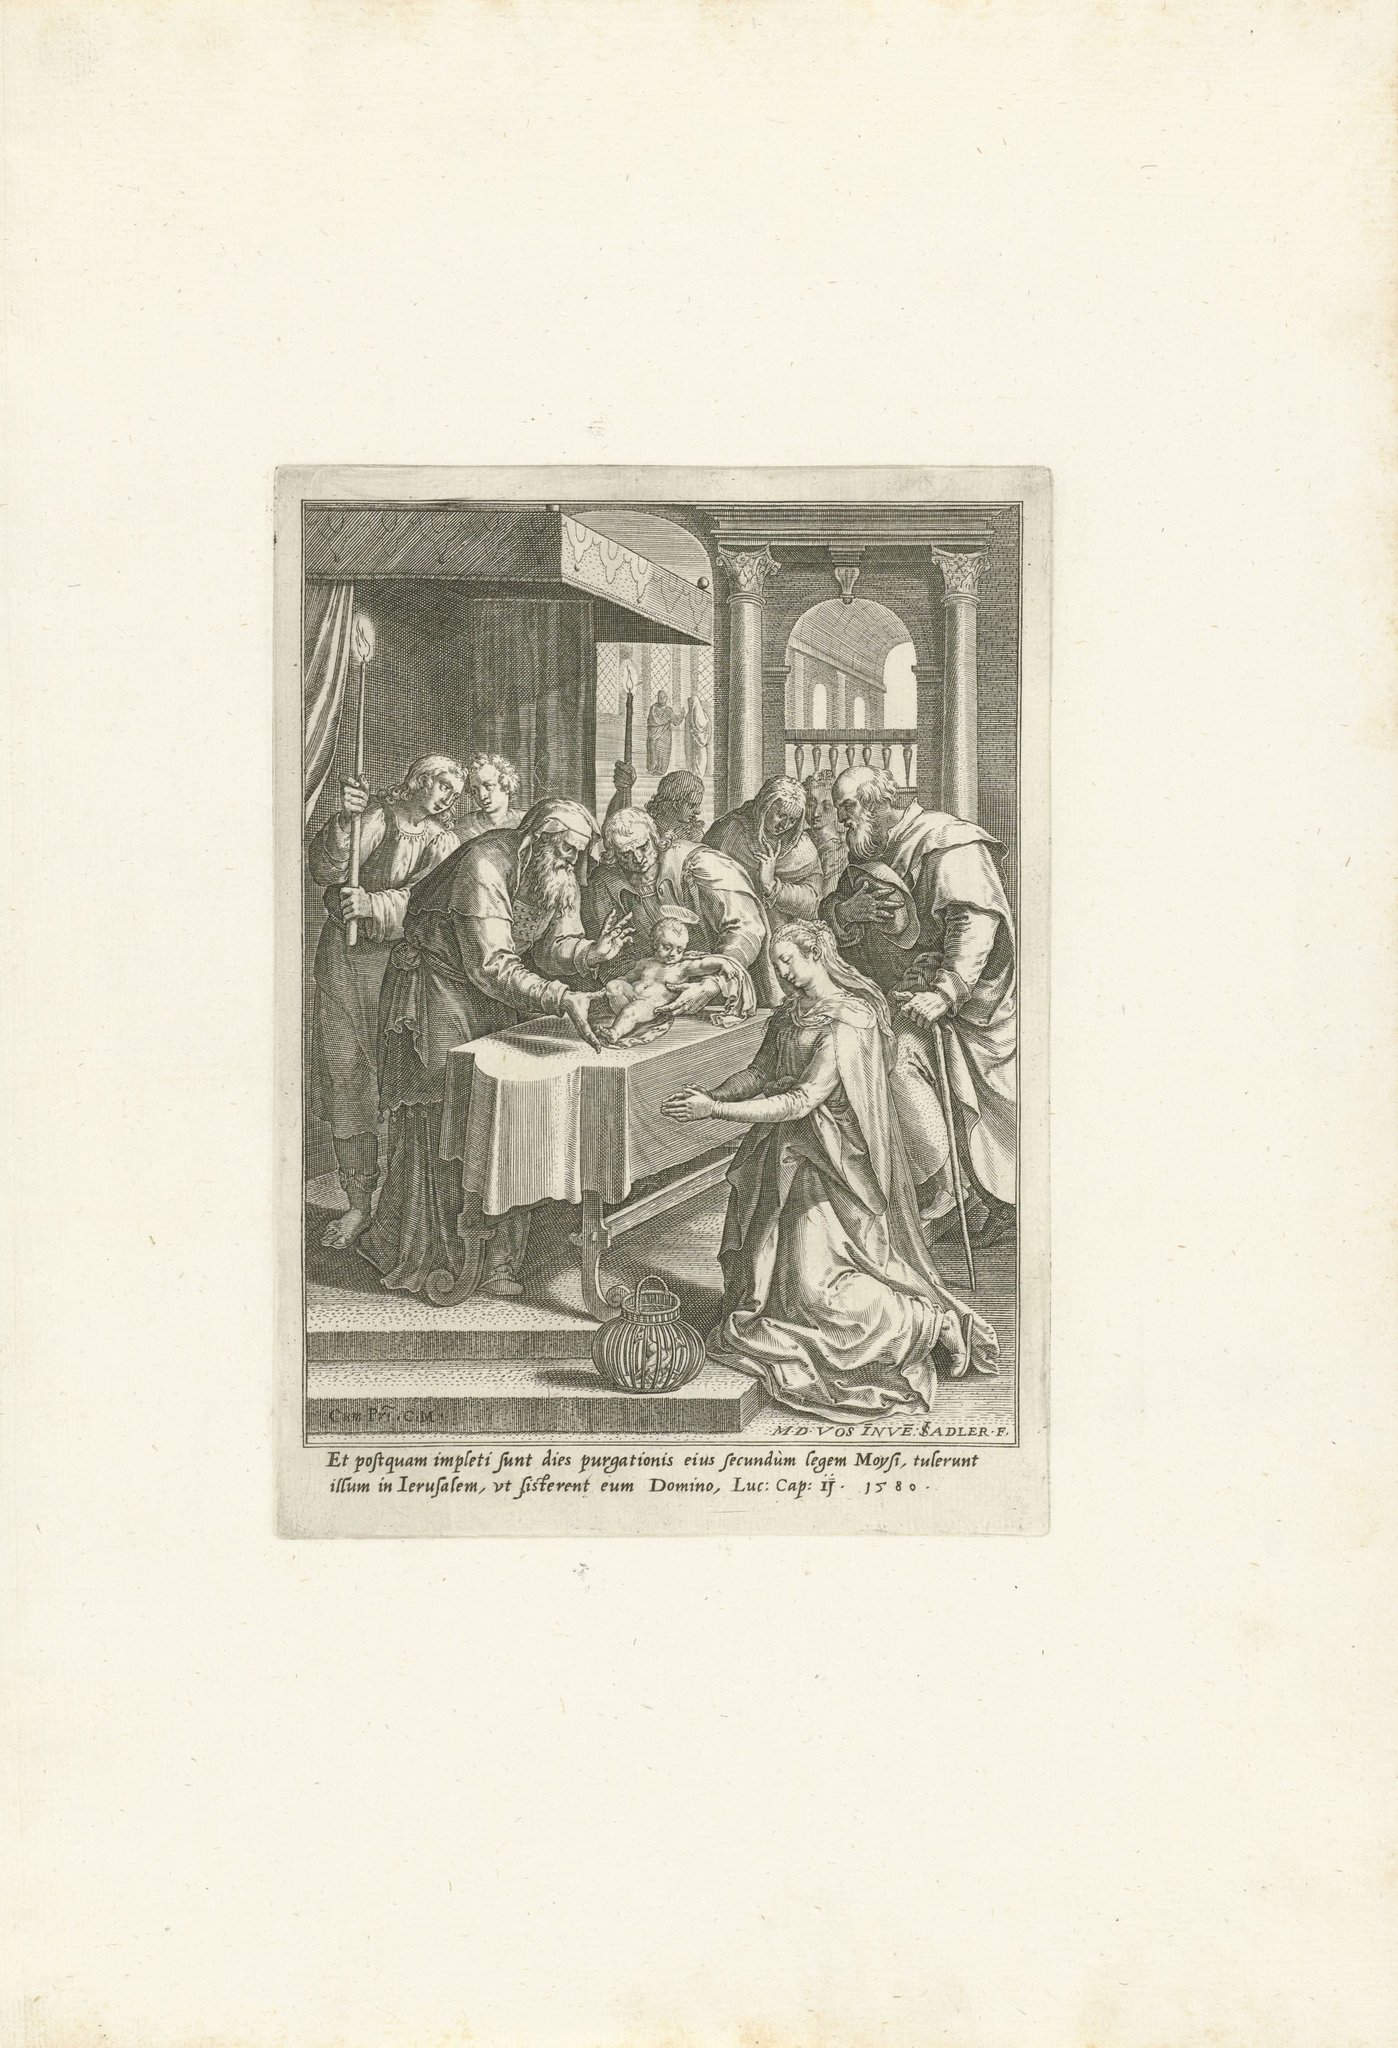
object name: print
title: Geboorte en eerste jaren van Christus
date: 1580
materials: paper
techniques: engraving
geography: cologne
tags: presentation of the christ-child in the temple, usually simeon (and anna) present (luke 2:22-39)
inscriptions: collector's mark: Lugt 2760, collector's mark: Lugt 2228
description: Het interieur van een tempel. Het Christuskind wordt op een tafel gelegd voor de hogepriester. Jozef en Maria staan voor de tafel. Naast Maria op de grond een mandje met twee duifjes die als offer dienen. De prent heeft een Latijns Bijbelcitaat als onderschrift en is de zevende prent van een twaalfdelige serie over de geboorte en de eerste jaren van Christus.